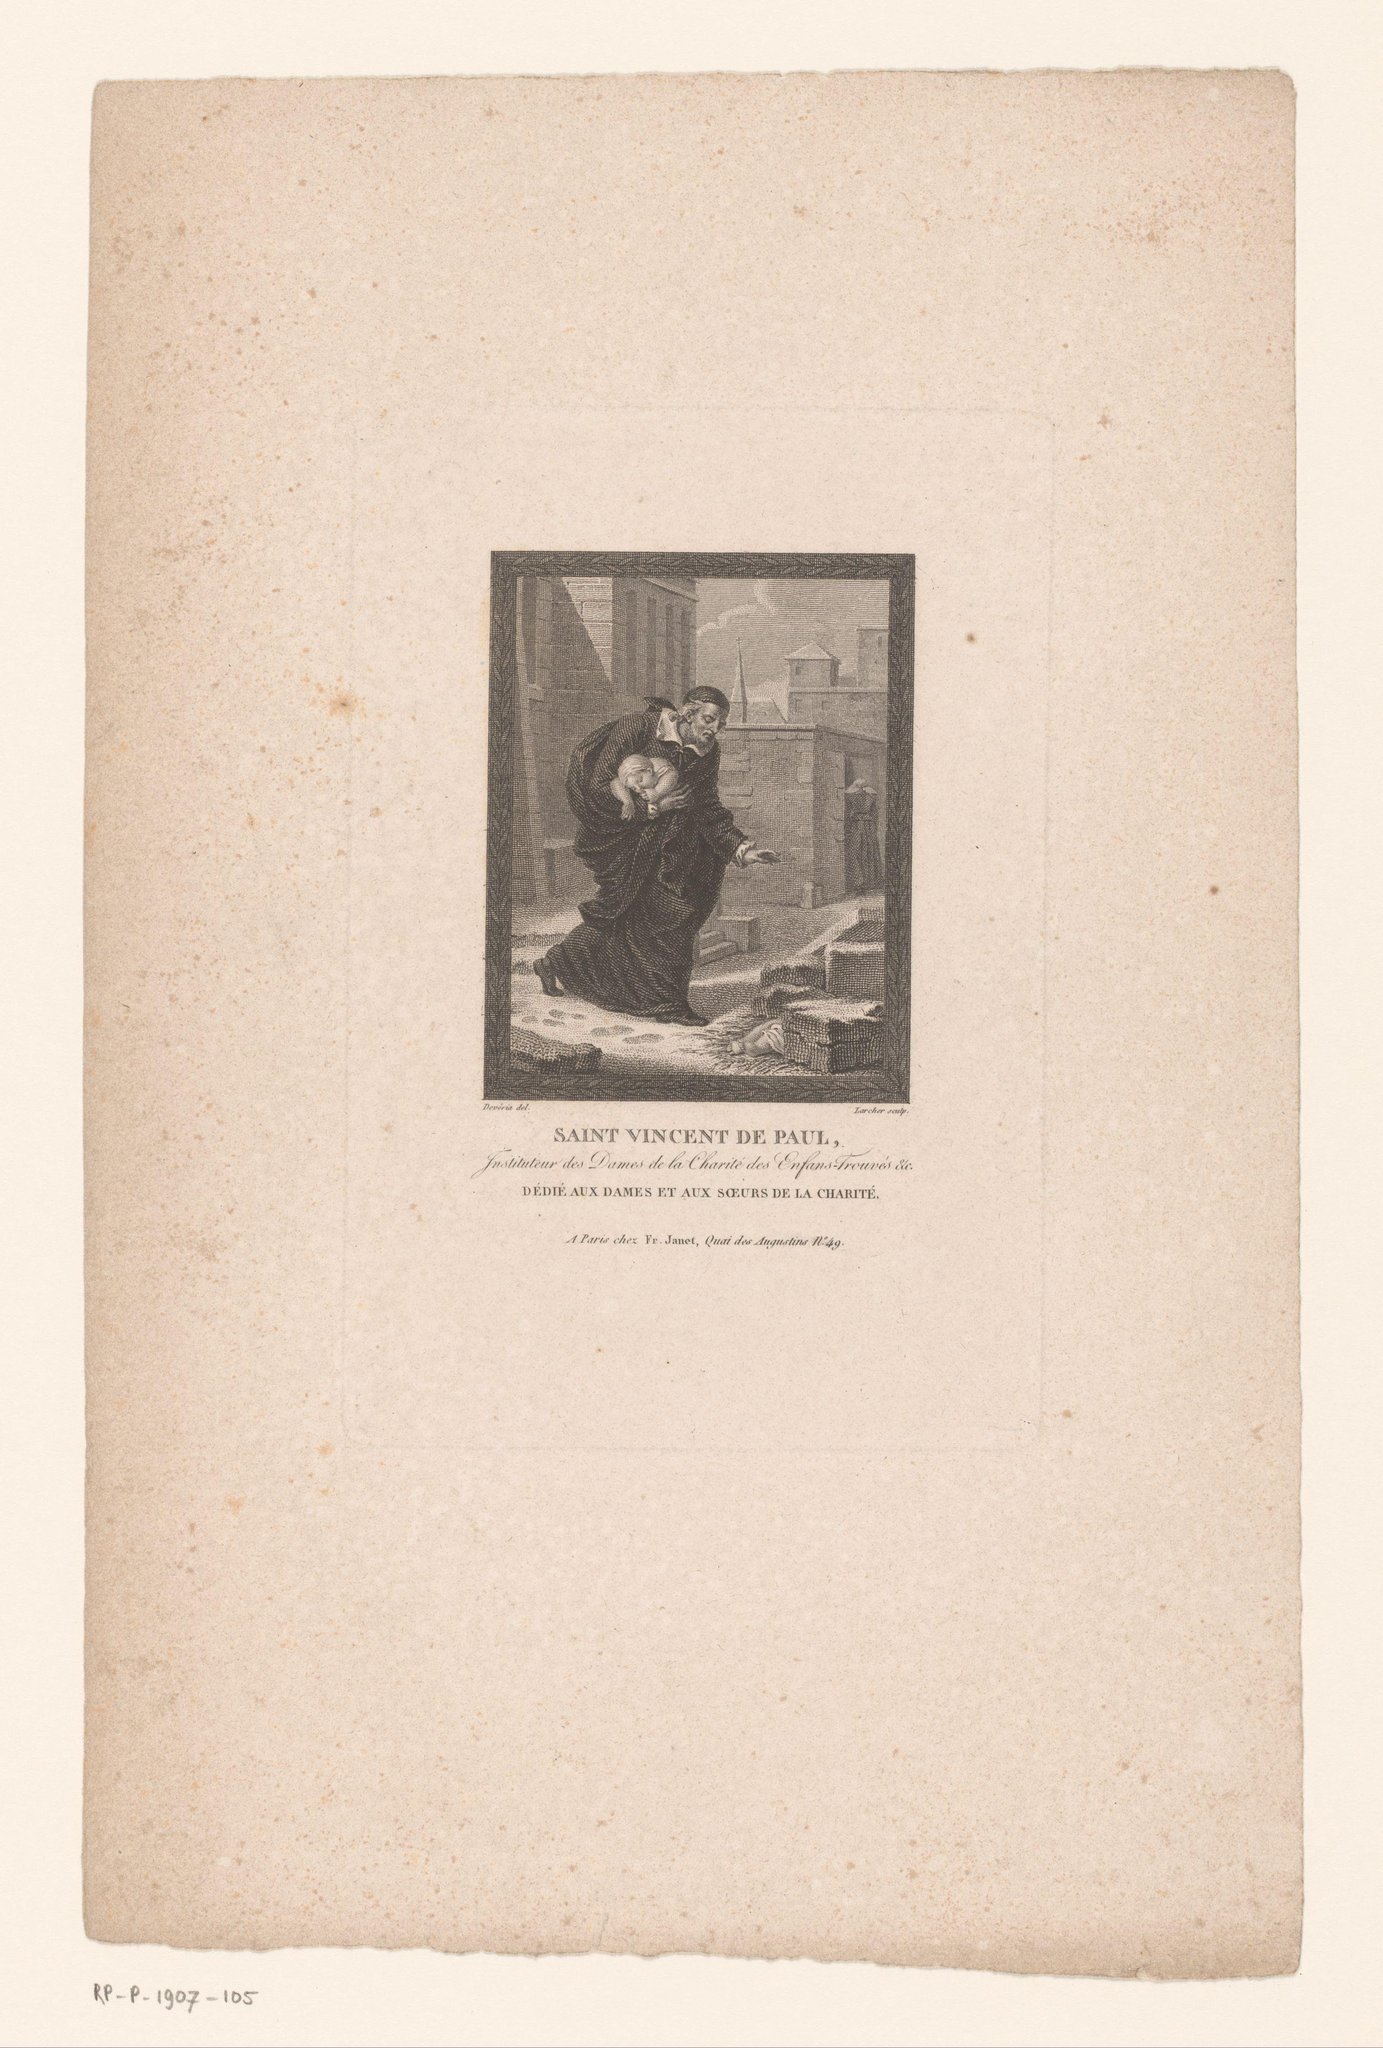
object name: print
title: Heilige Vincentius a Paulo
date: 1814-1843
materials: paper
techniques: engraving, etching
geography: paris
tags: st. vincent de paul taking care of orphans and foundlings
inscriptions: dedication: ‘Dédié aux Dames et aux Soeurs de la Charité.’, collector's mark: Lugt 2228